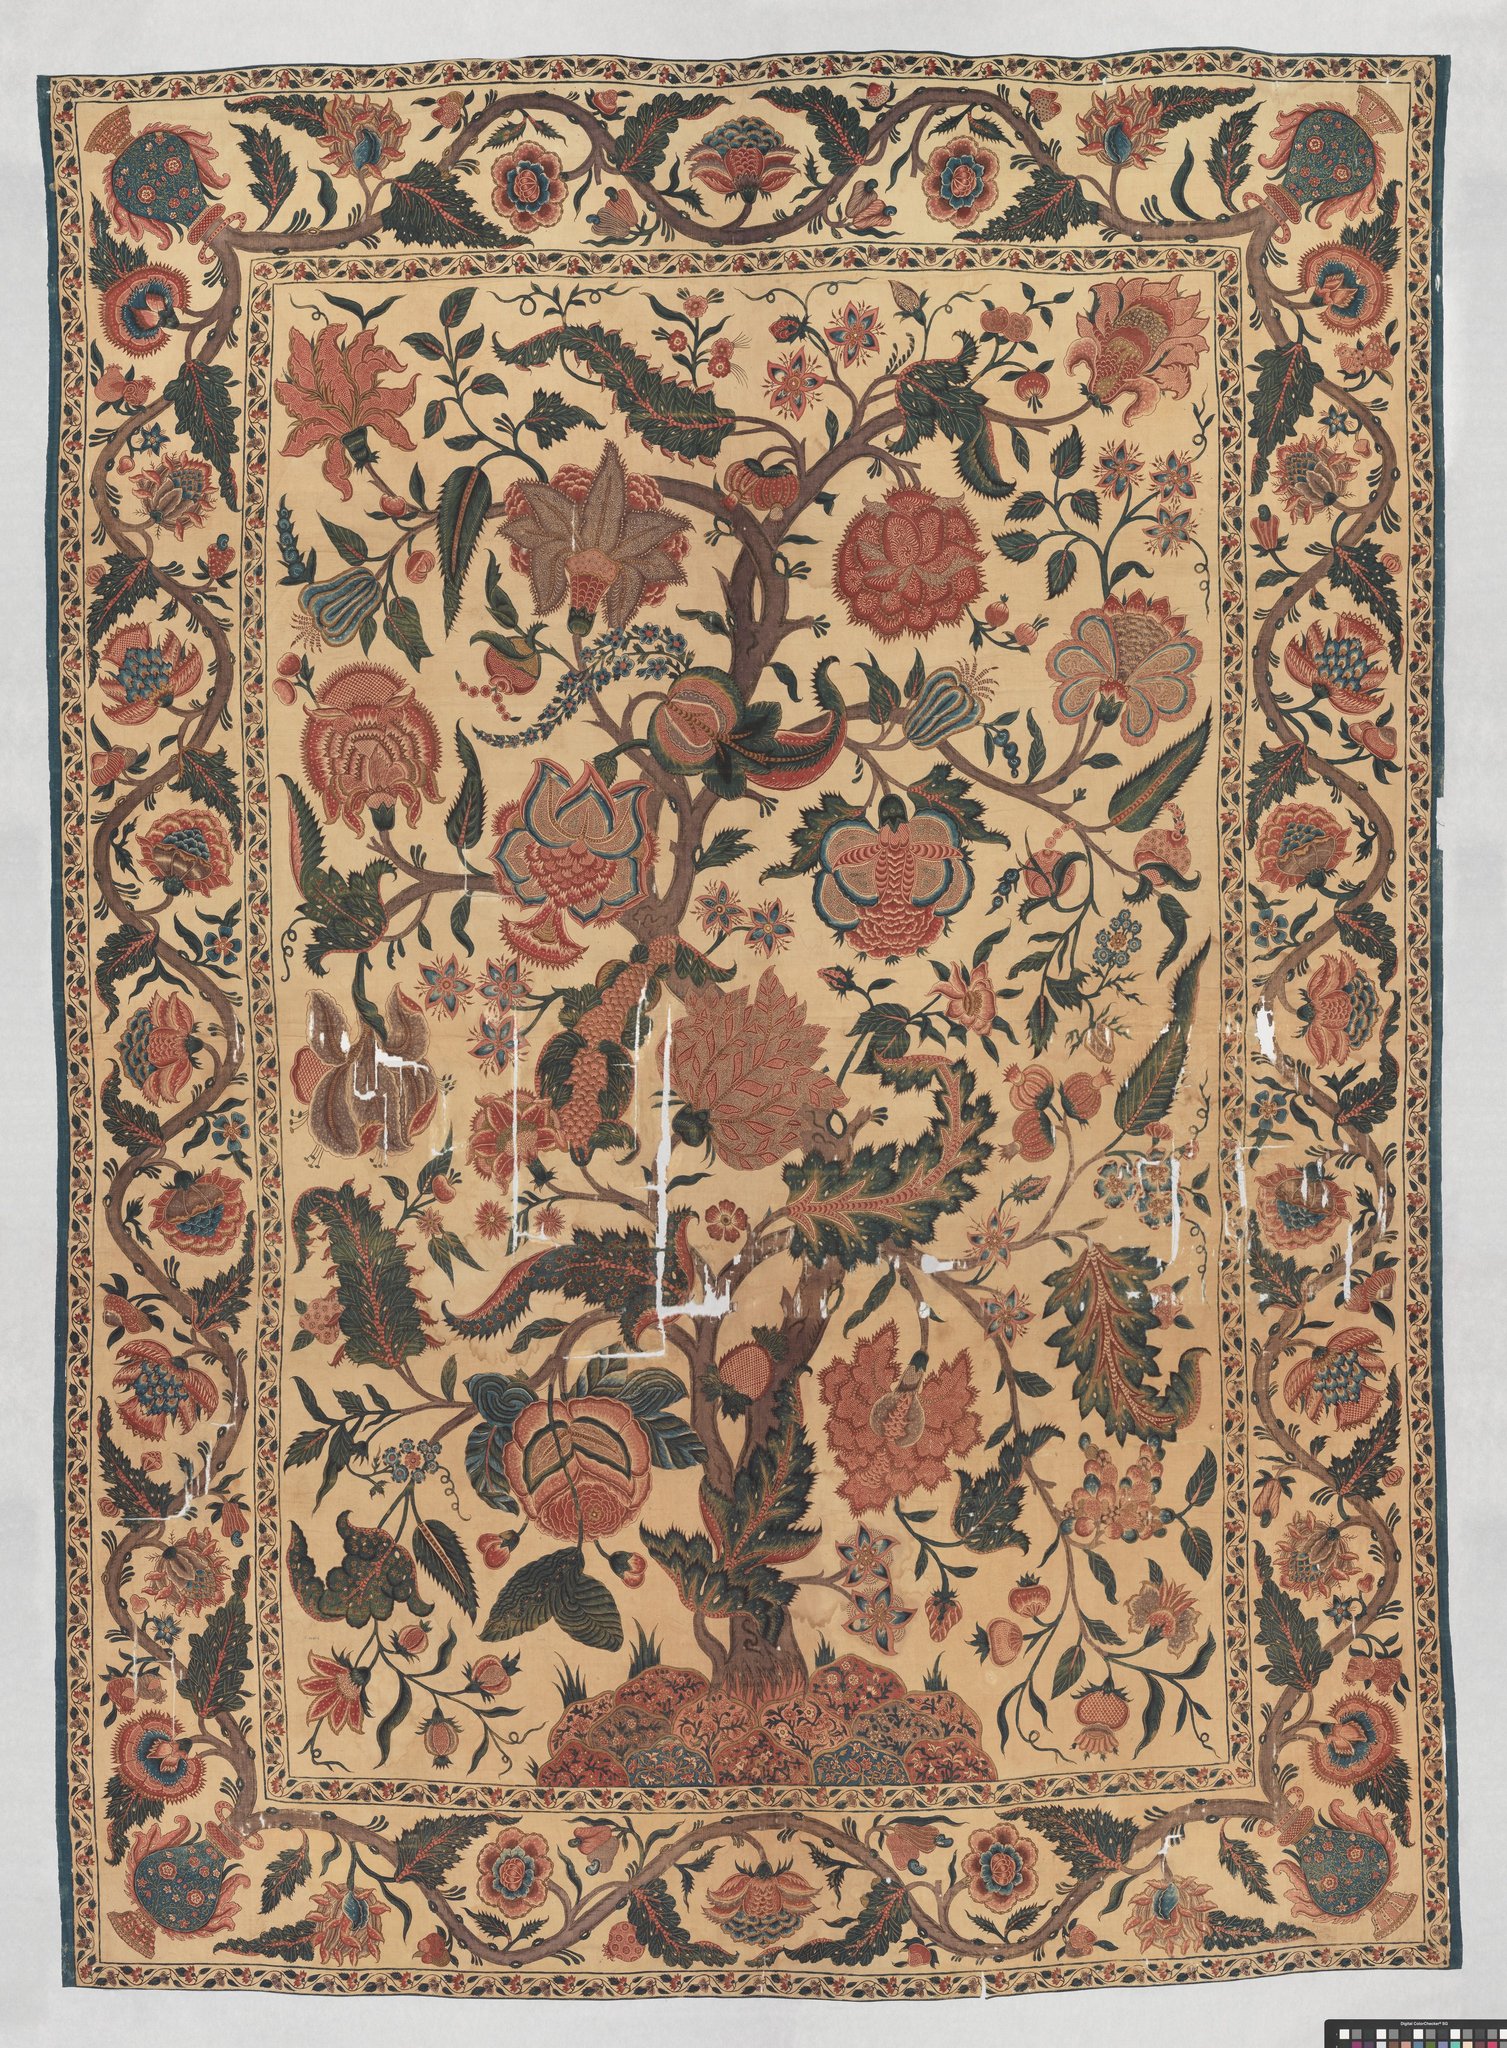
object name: bed cover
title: Bed Cover (Palampore)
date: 1701-1800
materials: cotton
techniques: dyeing, painting, weave, resist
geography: india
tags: flowers